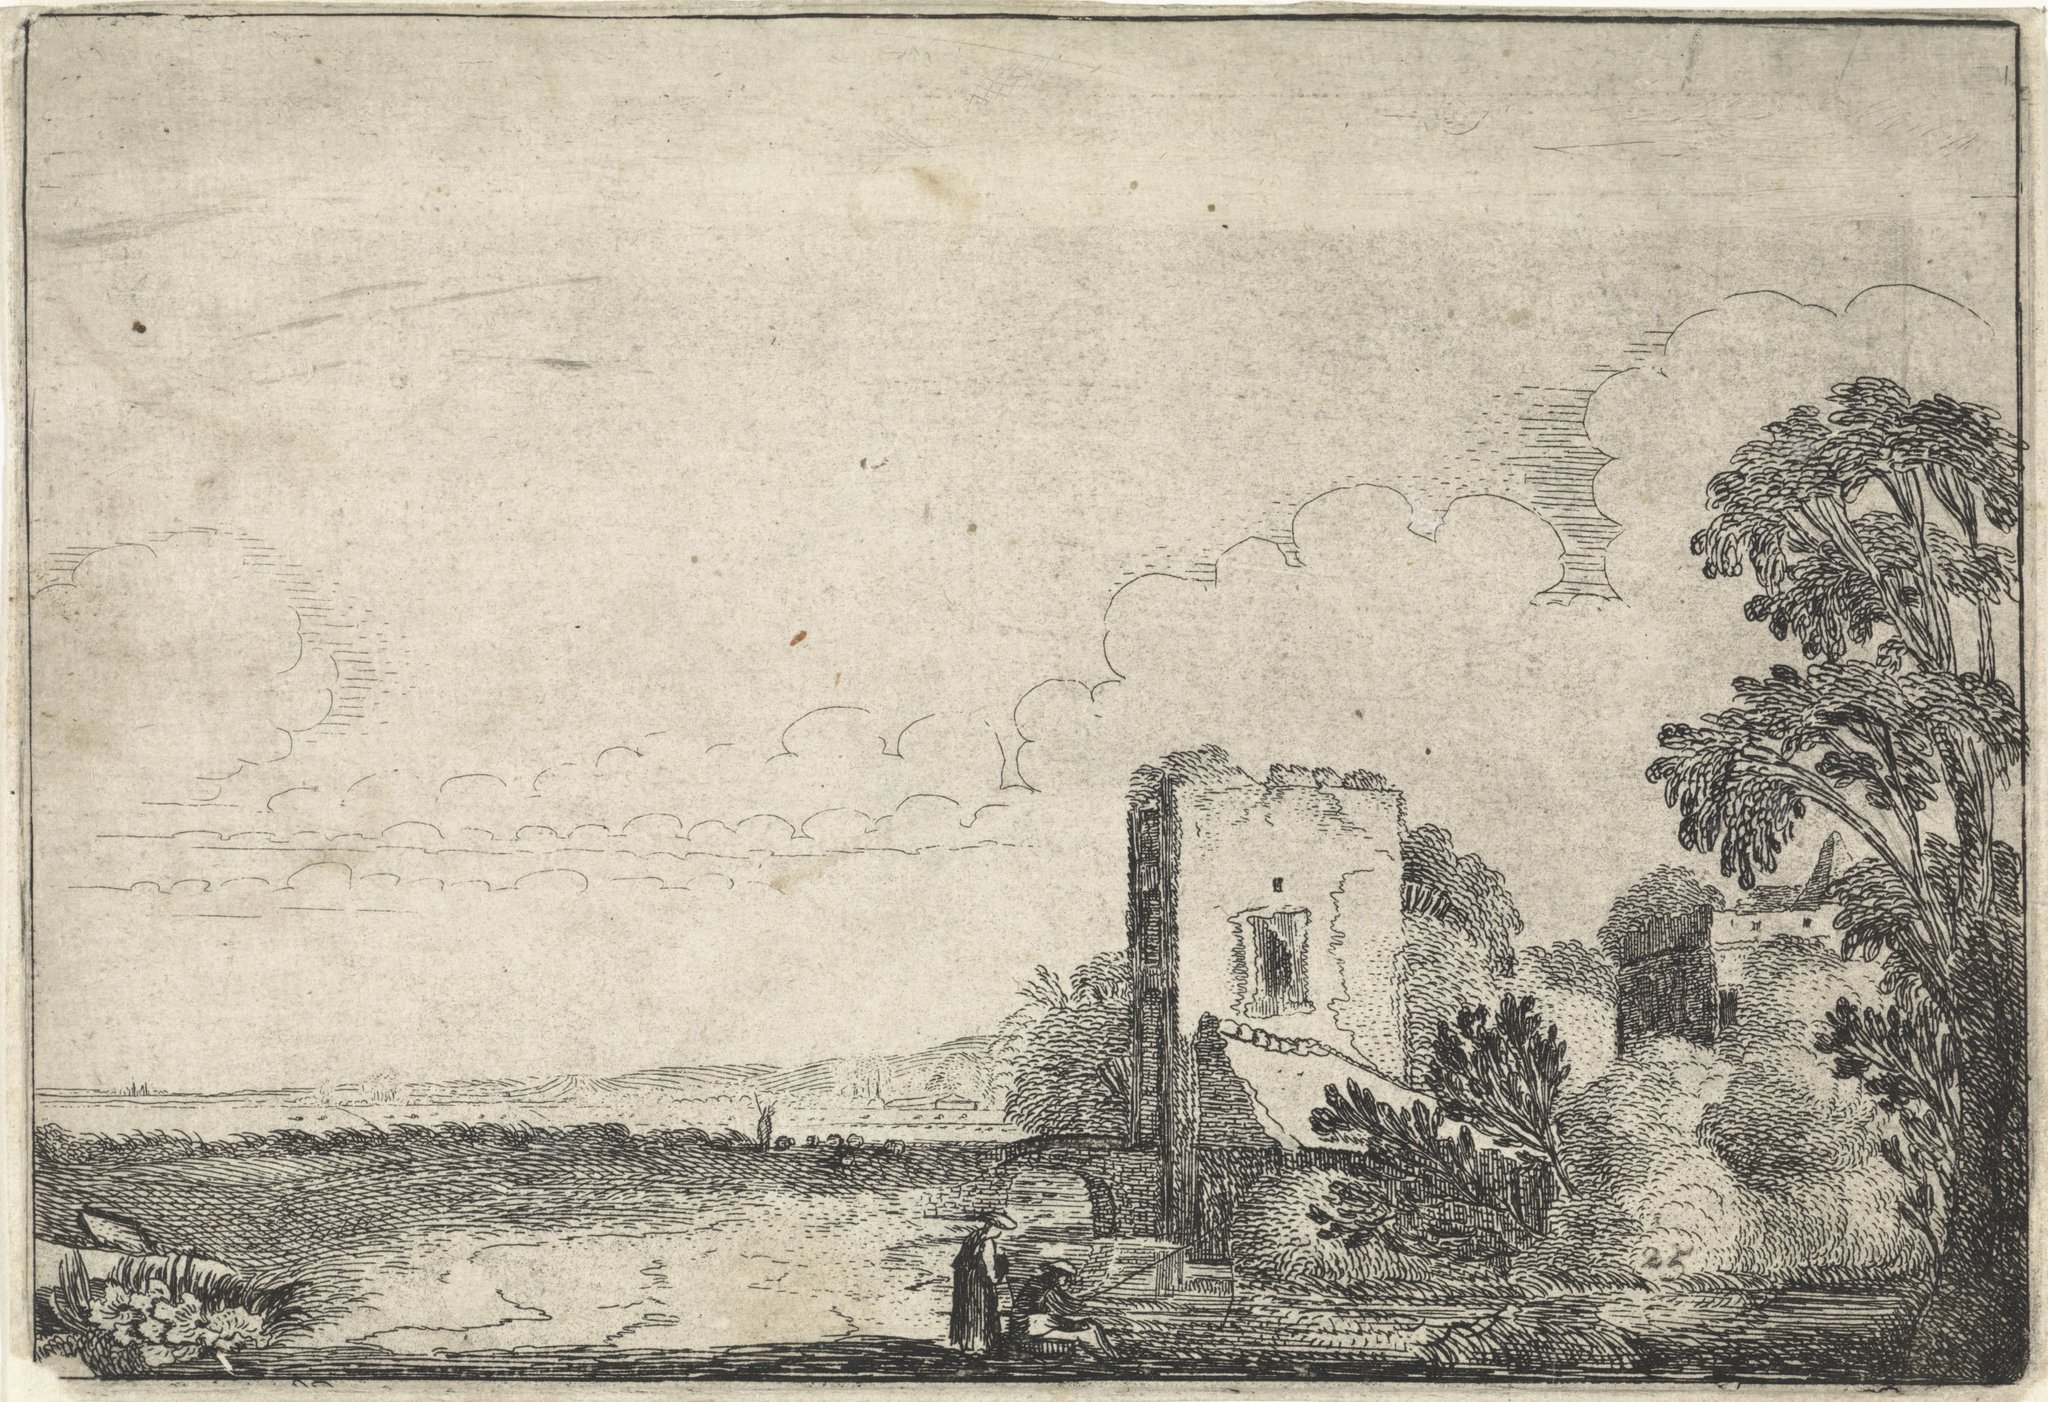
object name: print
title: Landschappen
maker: jan van de velde (ii)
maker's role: draughtsman, painter, print maker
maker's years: 1593-1641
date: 1616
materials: paper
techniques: etching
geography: northern netherlands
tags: landscape with bridge, viaduct or aqueduct, landscape with tower or castle, angling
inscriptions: collector's mark: Lugt 964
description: Een hengelaar en een tweede figuur aan de oever van een stroom bij een toren in een landschap. Voor de toren een stenen brug. Vijfentwintigste prent van een serie van in totaal 52 prenten met landschappen, verdeeld over twee delen van elk 26 prenten.